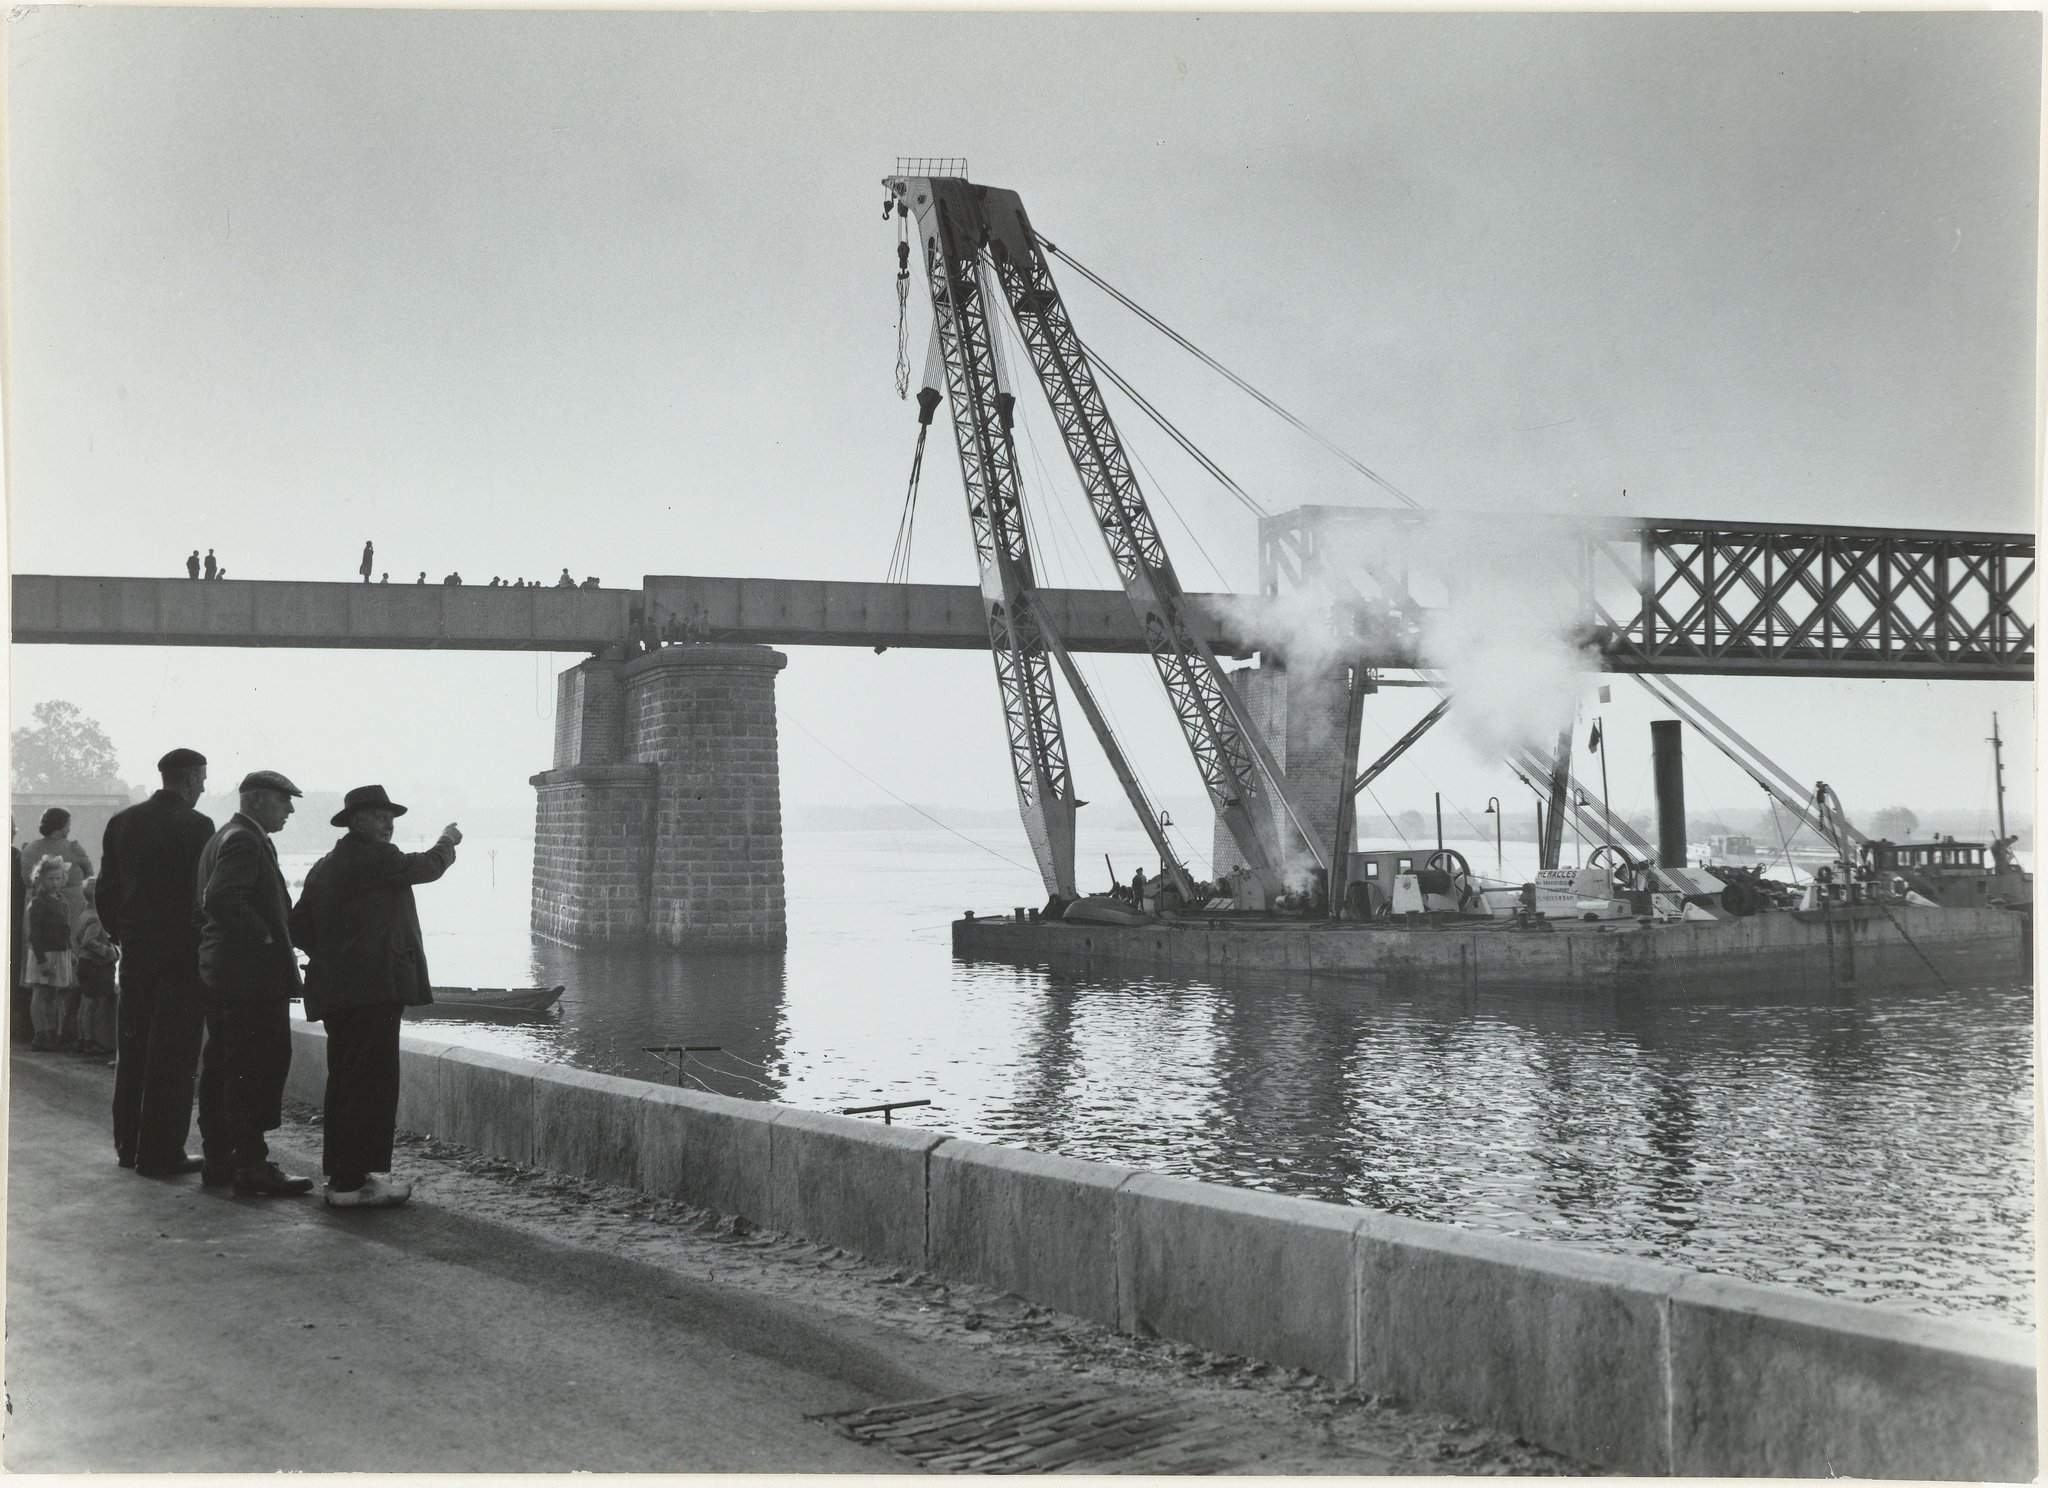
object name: photograph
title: Werkzaamheden aan een brug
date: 1950-1960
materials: photographic support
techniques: photography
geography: netherlands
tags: bridge, netherlands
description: Een kraan is bezig vanaf een ponton een deel van een brug te plaatsen. Aan de wal staan mensen te kijken.